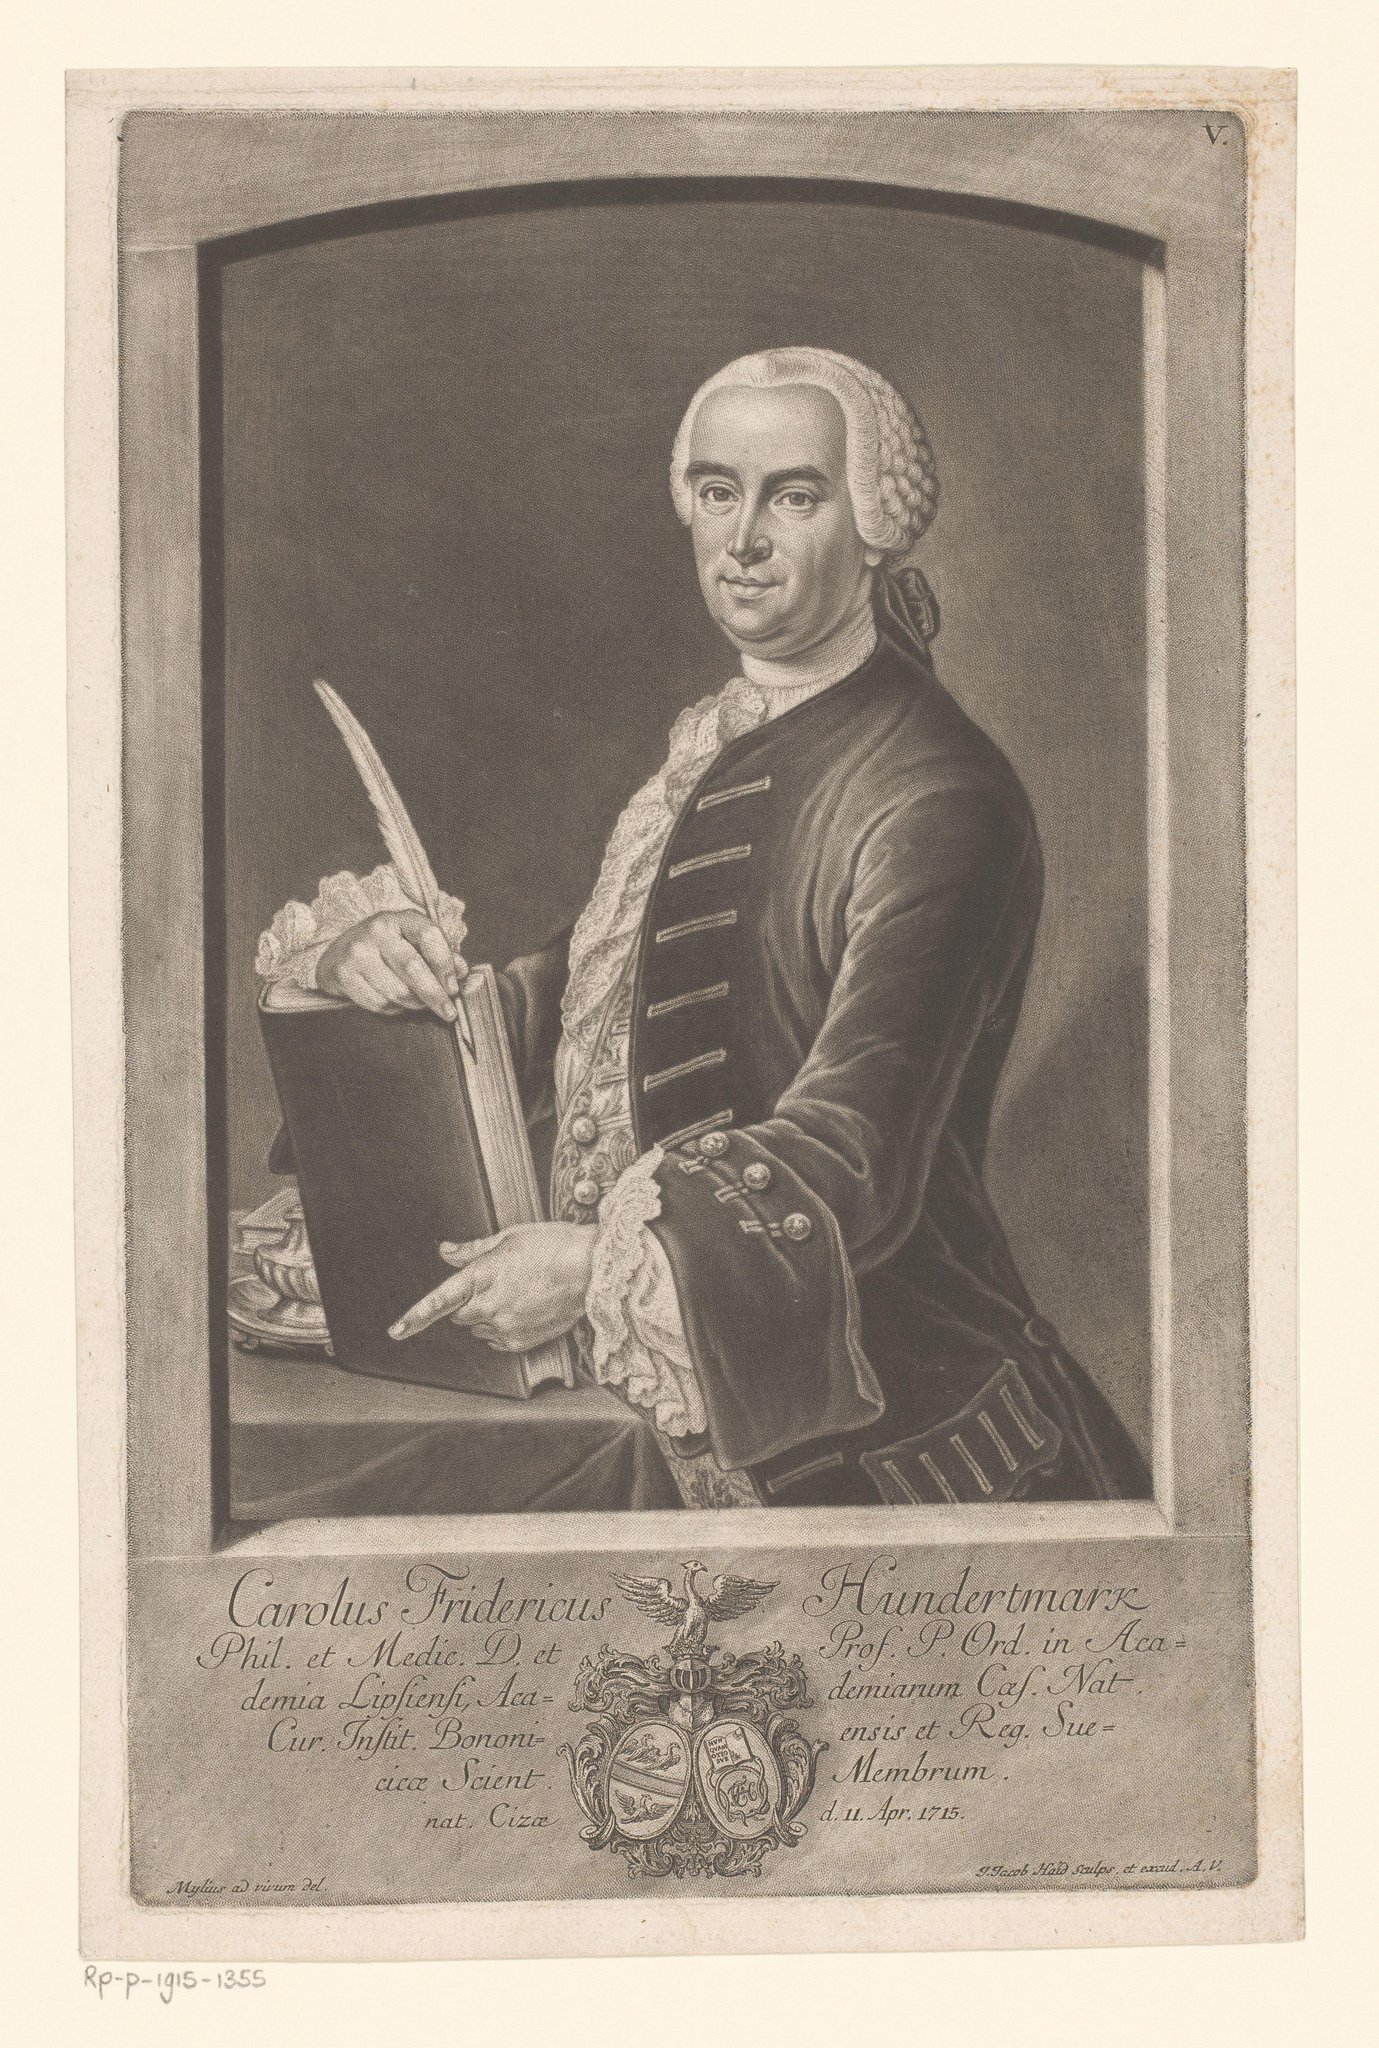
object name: print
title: Portret van Carl Friedrich Hundermark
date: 1757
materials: paper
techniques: etching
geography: augsburg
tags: writing tools, historical persons, armorial bearing, heraldry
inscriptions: collector's mark: Lugt 2228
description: Prent gebruikt voor: Haid, Johann Jacob. Neue Sammlung von Bildnissen gelehrter (...) noch lebender Männer. Augsburg: Johann Jacob Haid, 1757.